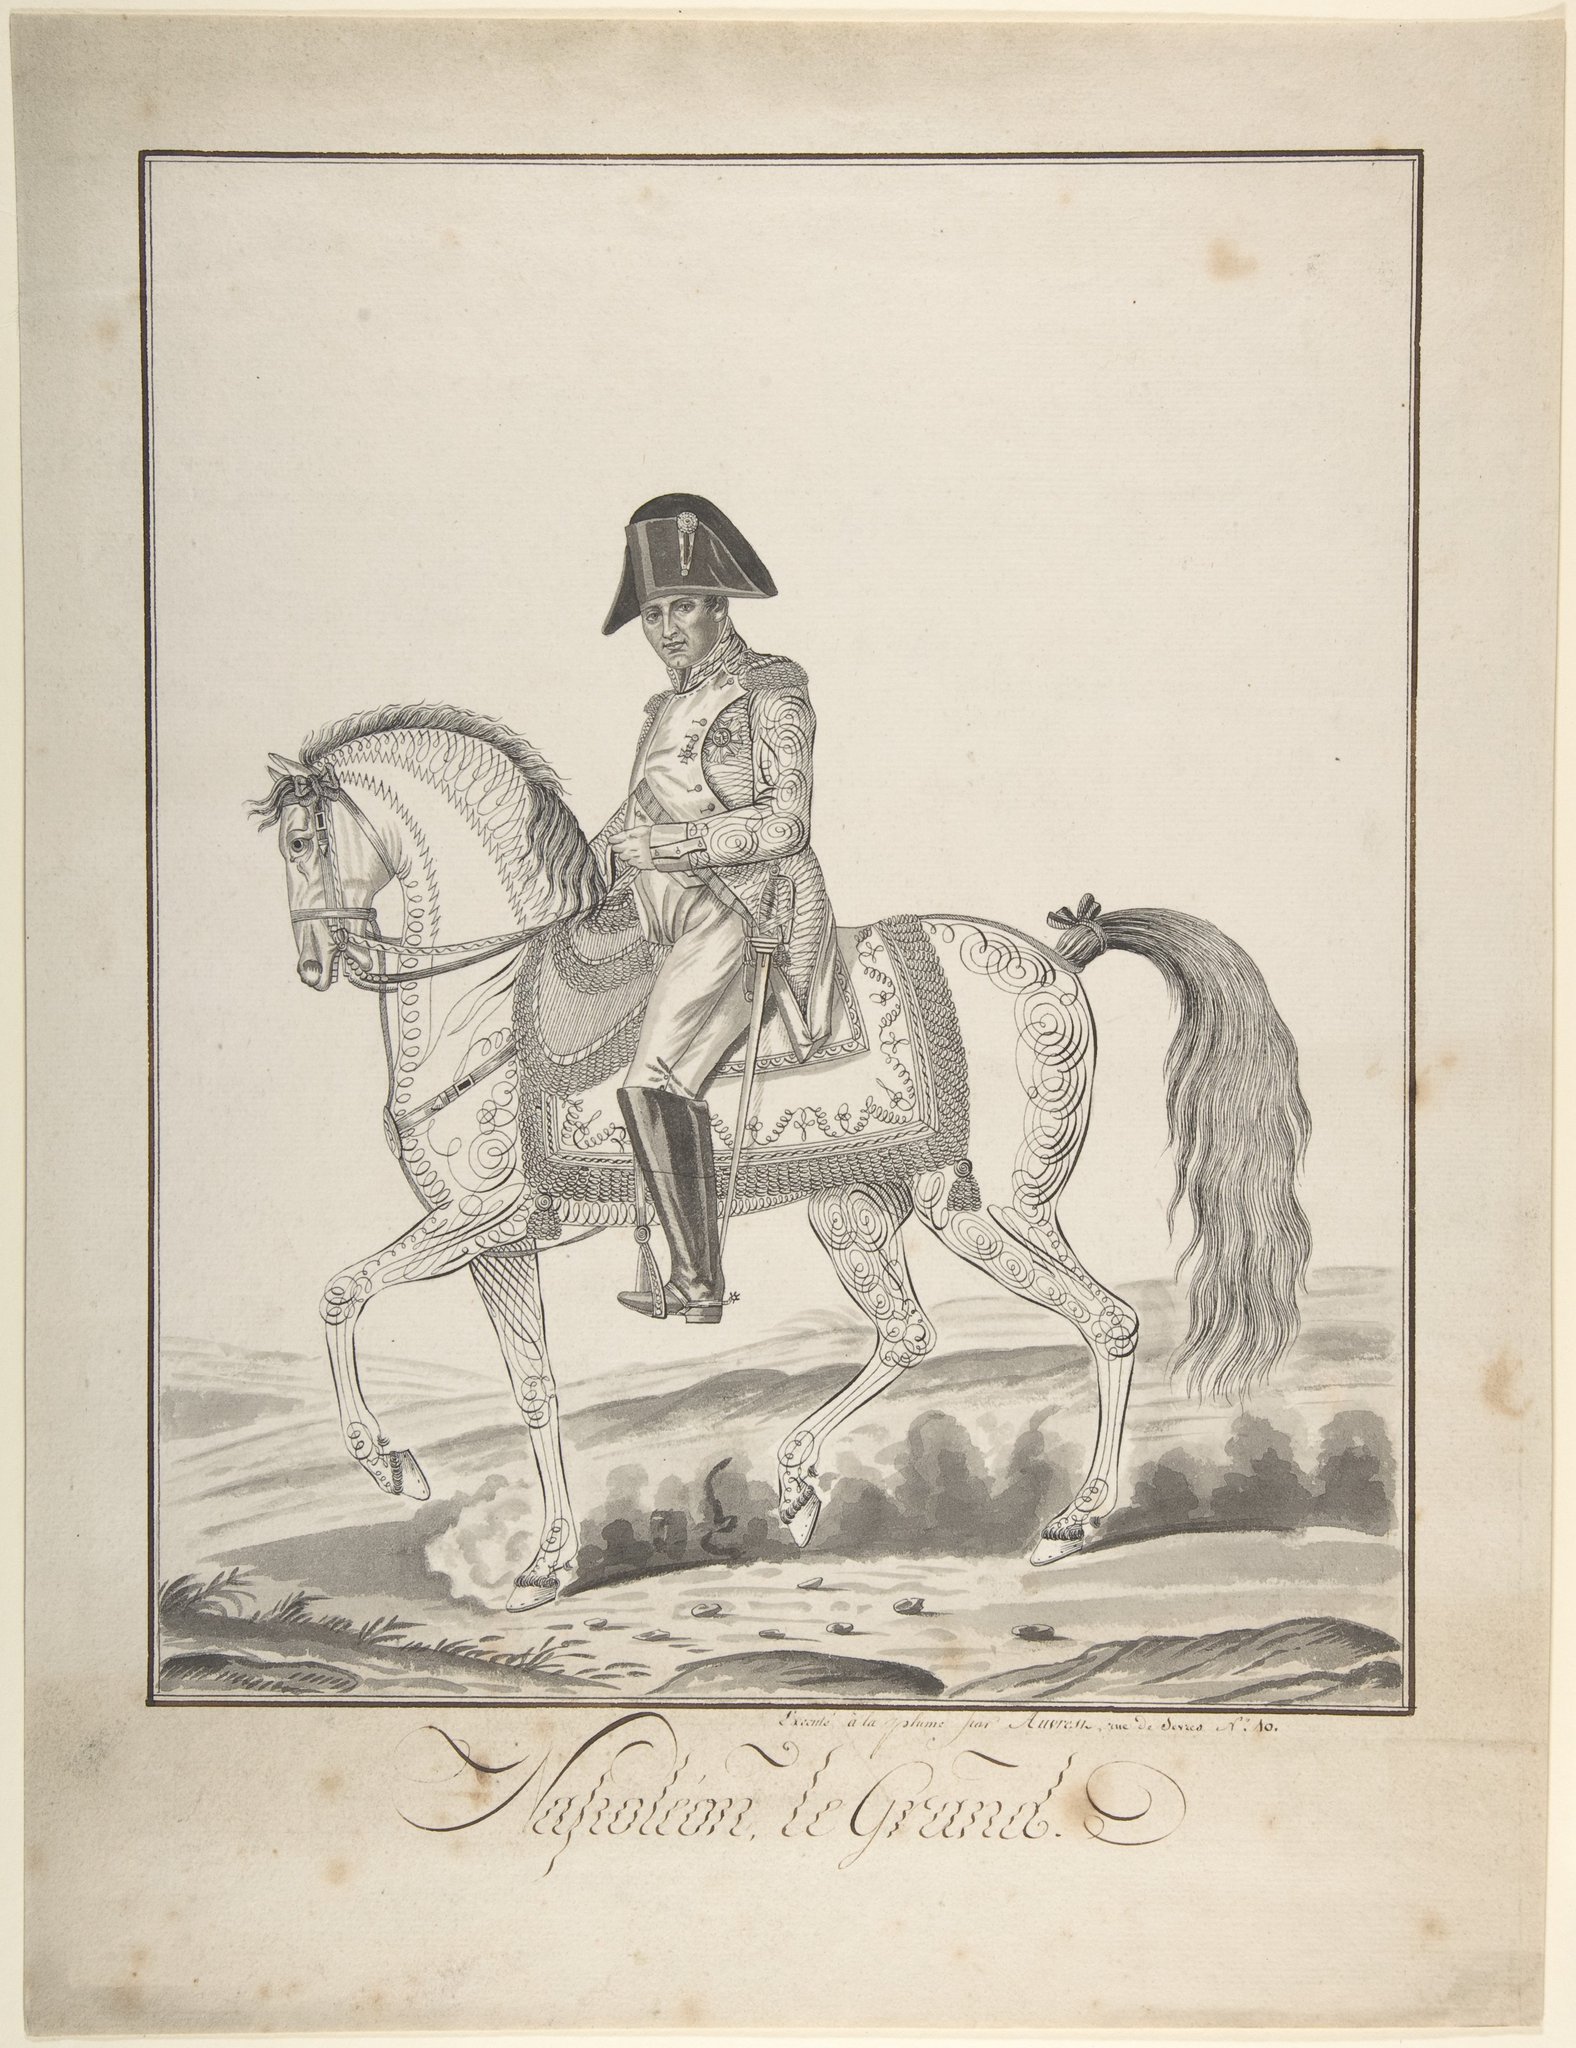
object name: drawing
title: Equestrian Portrait of Napoleon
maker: auvrest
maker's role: artist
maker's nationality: french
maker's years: 1750-1850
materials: ink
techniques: brush, pen, wash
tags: napoleon i,portraits,horses